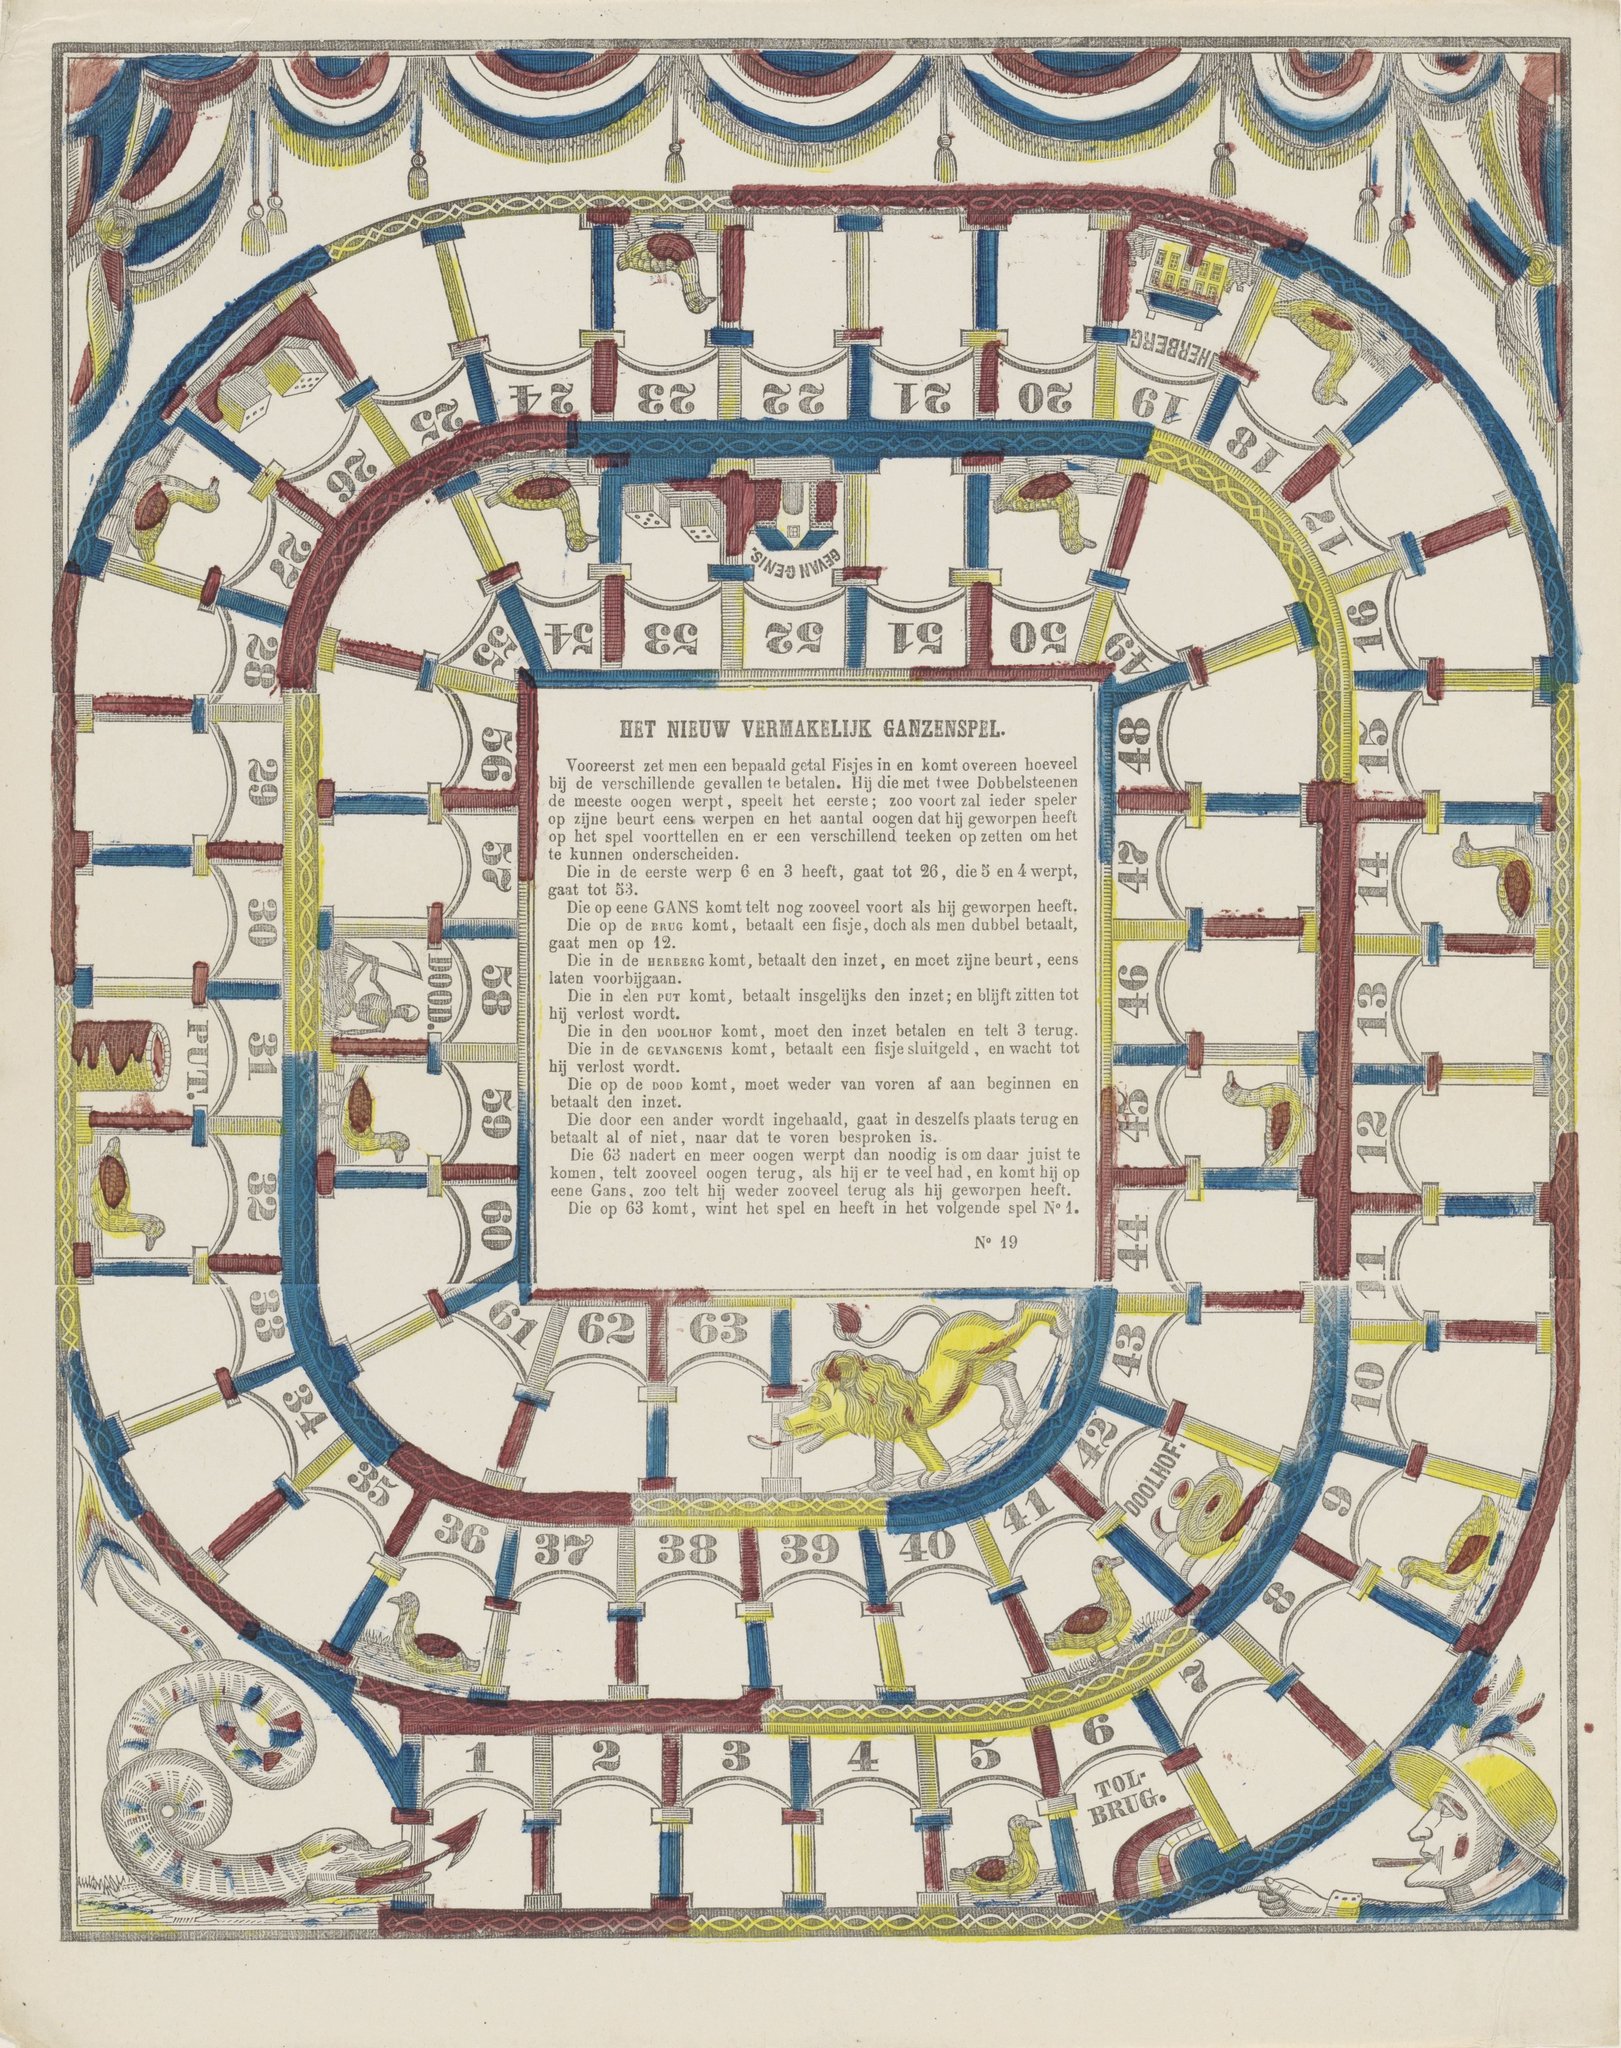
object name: popular print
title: Het nieuw vermakelijk ganzenspel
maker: Anonymous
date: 1848-1881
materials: paper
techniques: colour, letterpress printing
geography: den bosch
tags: goose-game, board-games of chance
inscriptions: collector's mark: Lugt 2760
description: Een rechthoekig ganzenbordspel met vakjes genummerd 1-63. In het midden de spelregels. Genummerd midden: No 19.